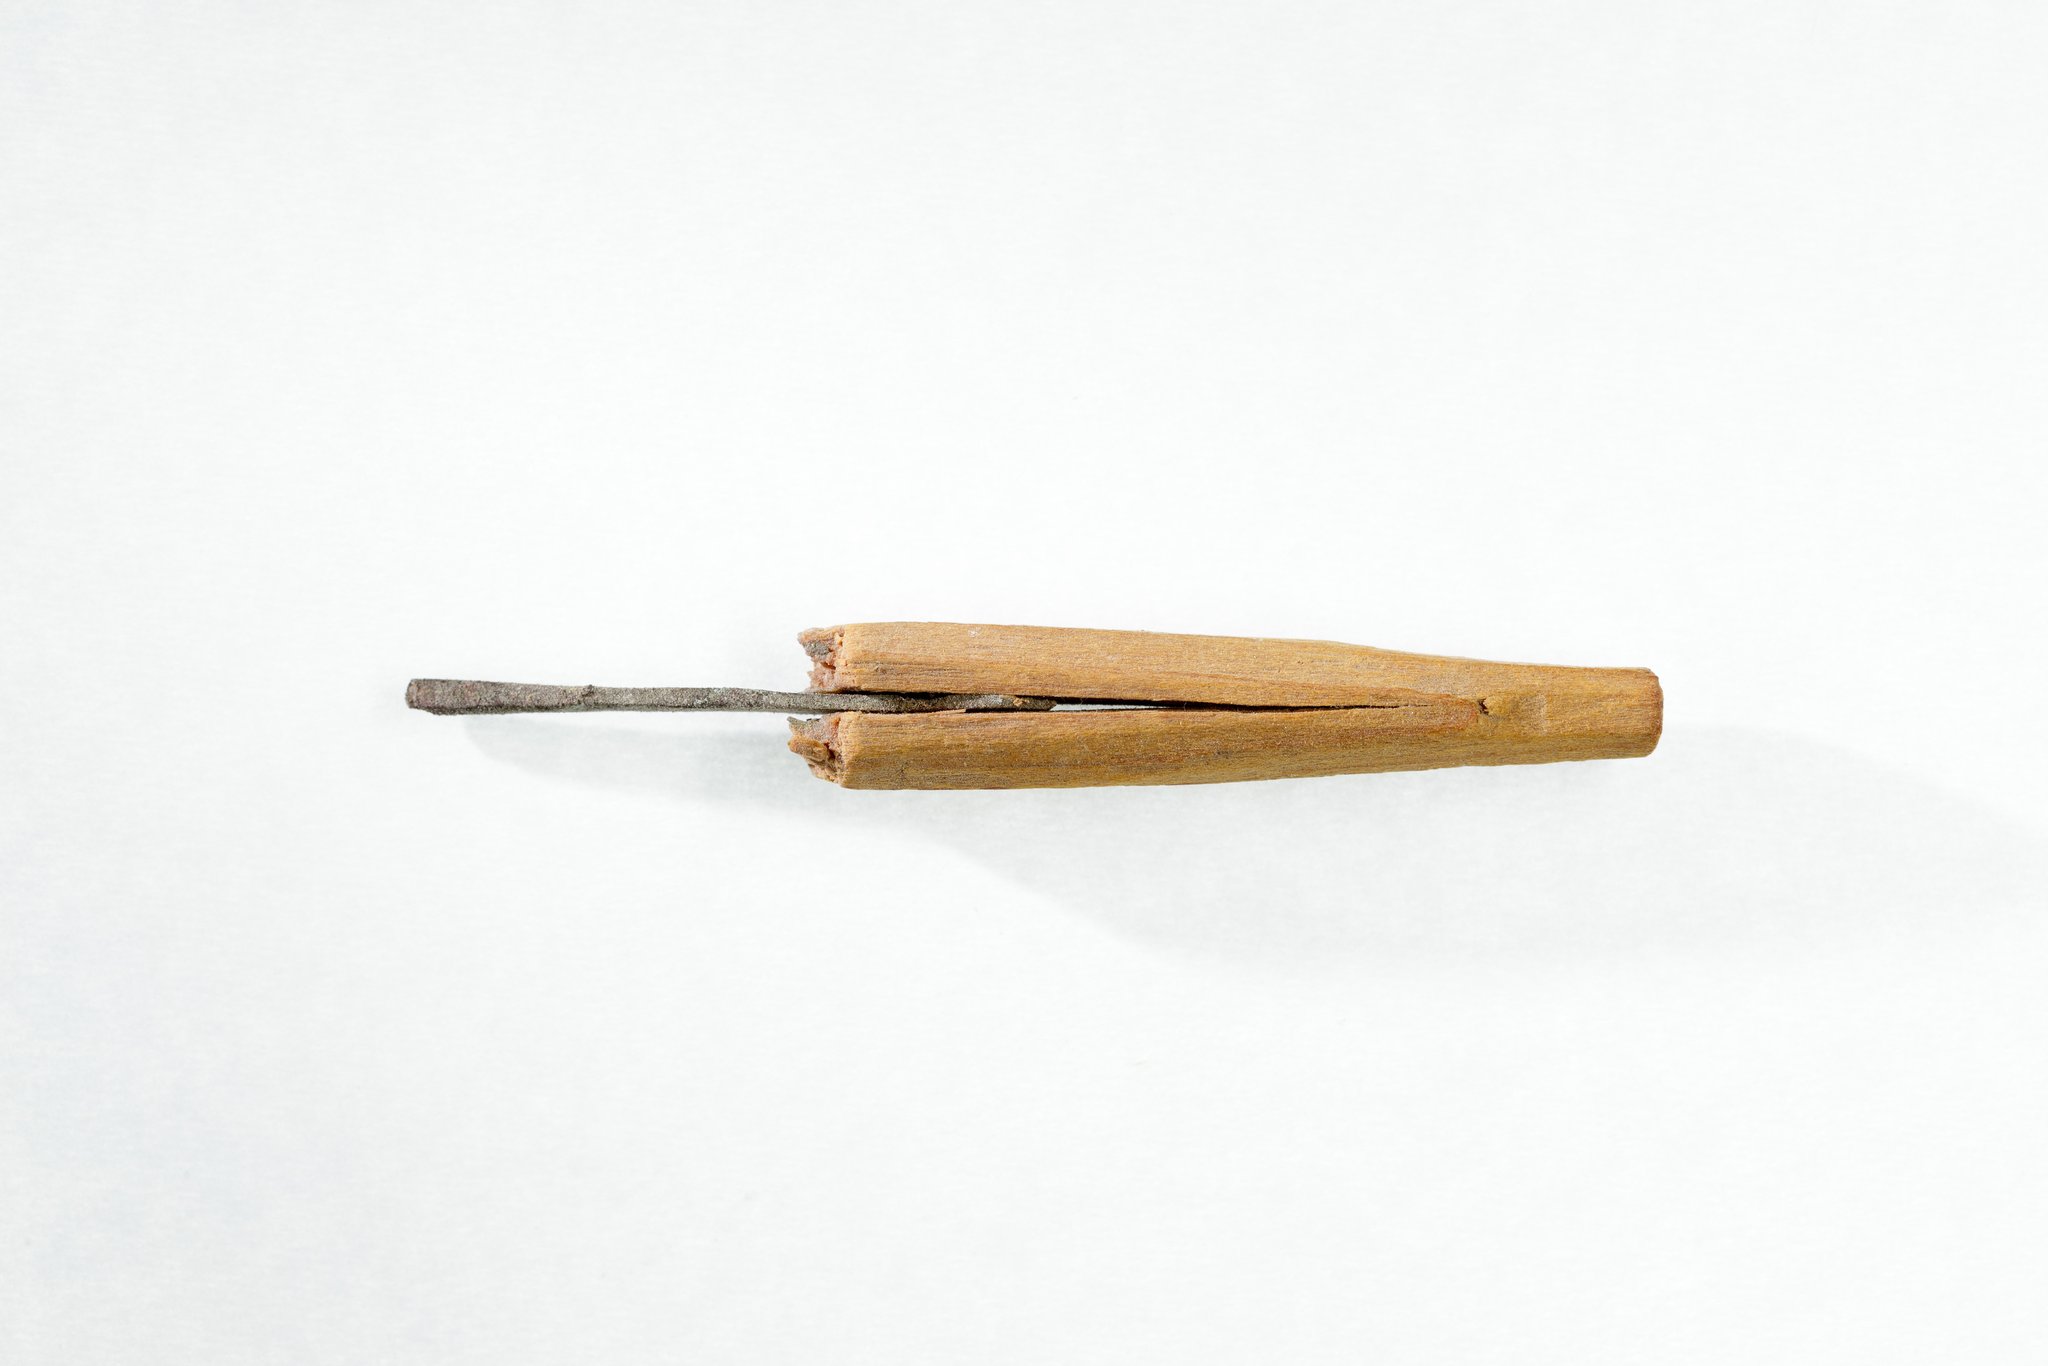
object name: chisel, model, tool, senenmut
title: Model Chisel from a Foundation Deposit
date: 1479-1458 BCE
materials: bronze, copper alloy, wood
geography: egypt